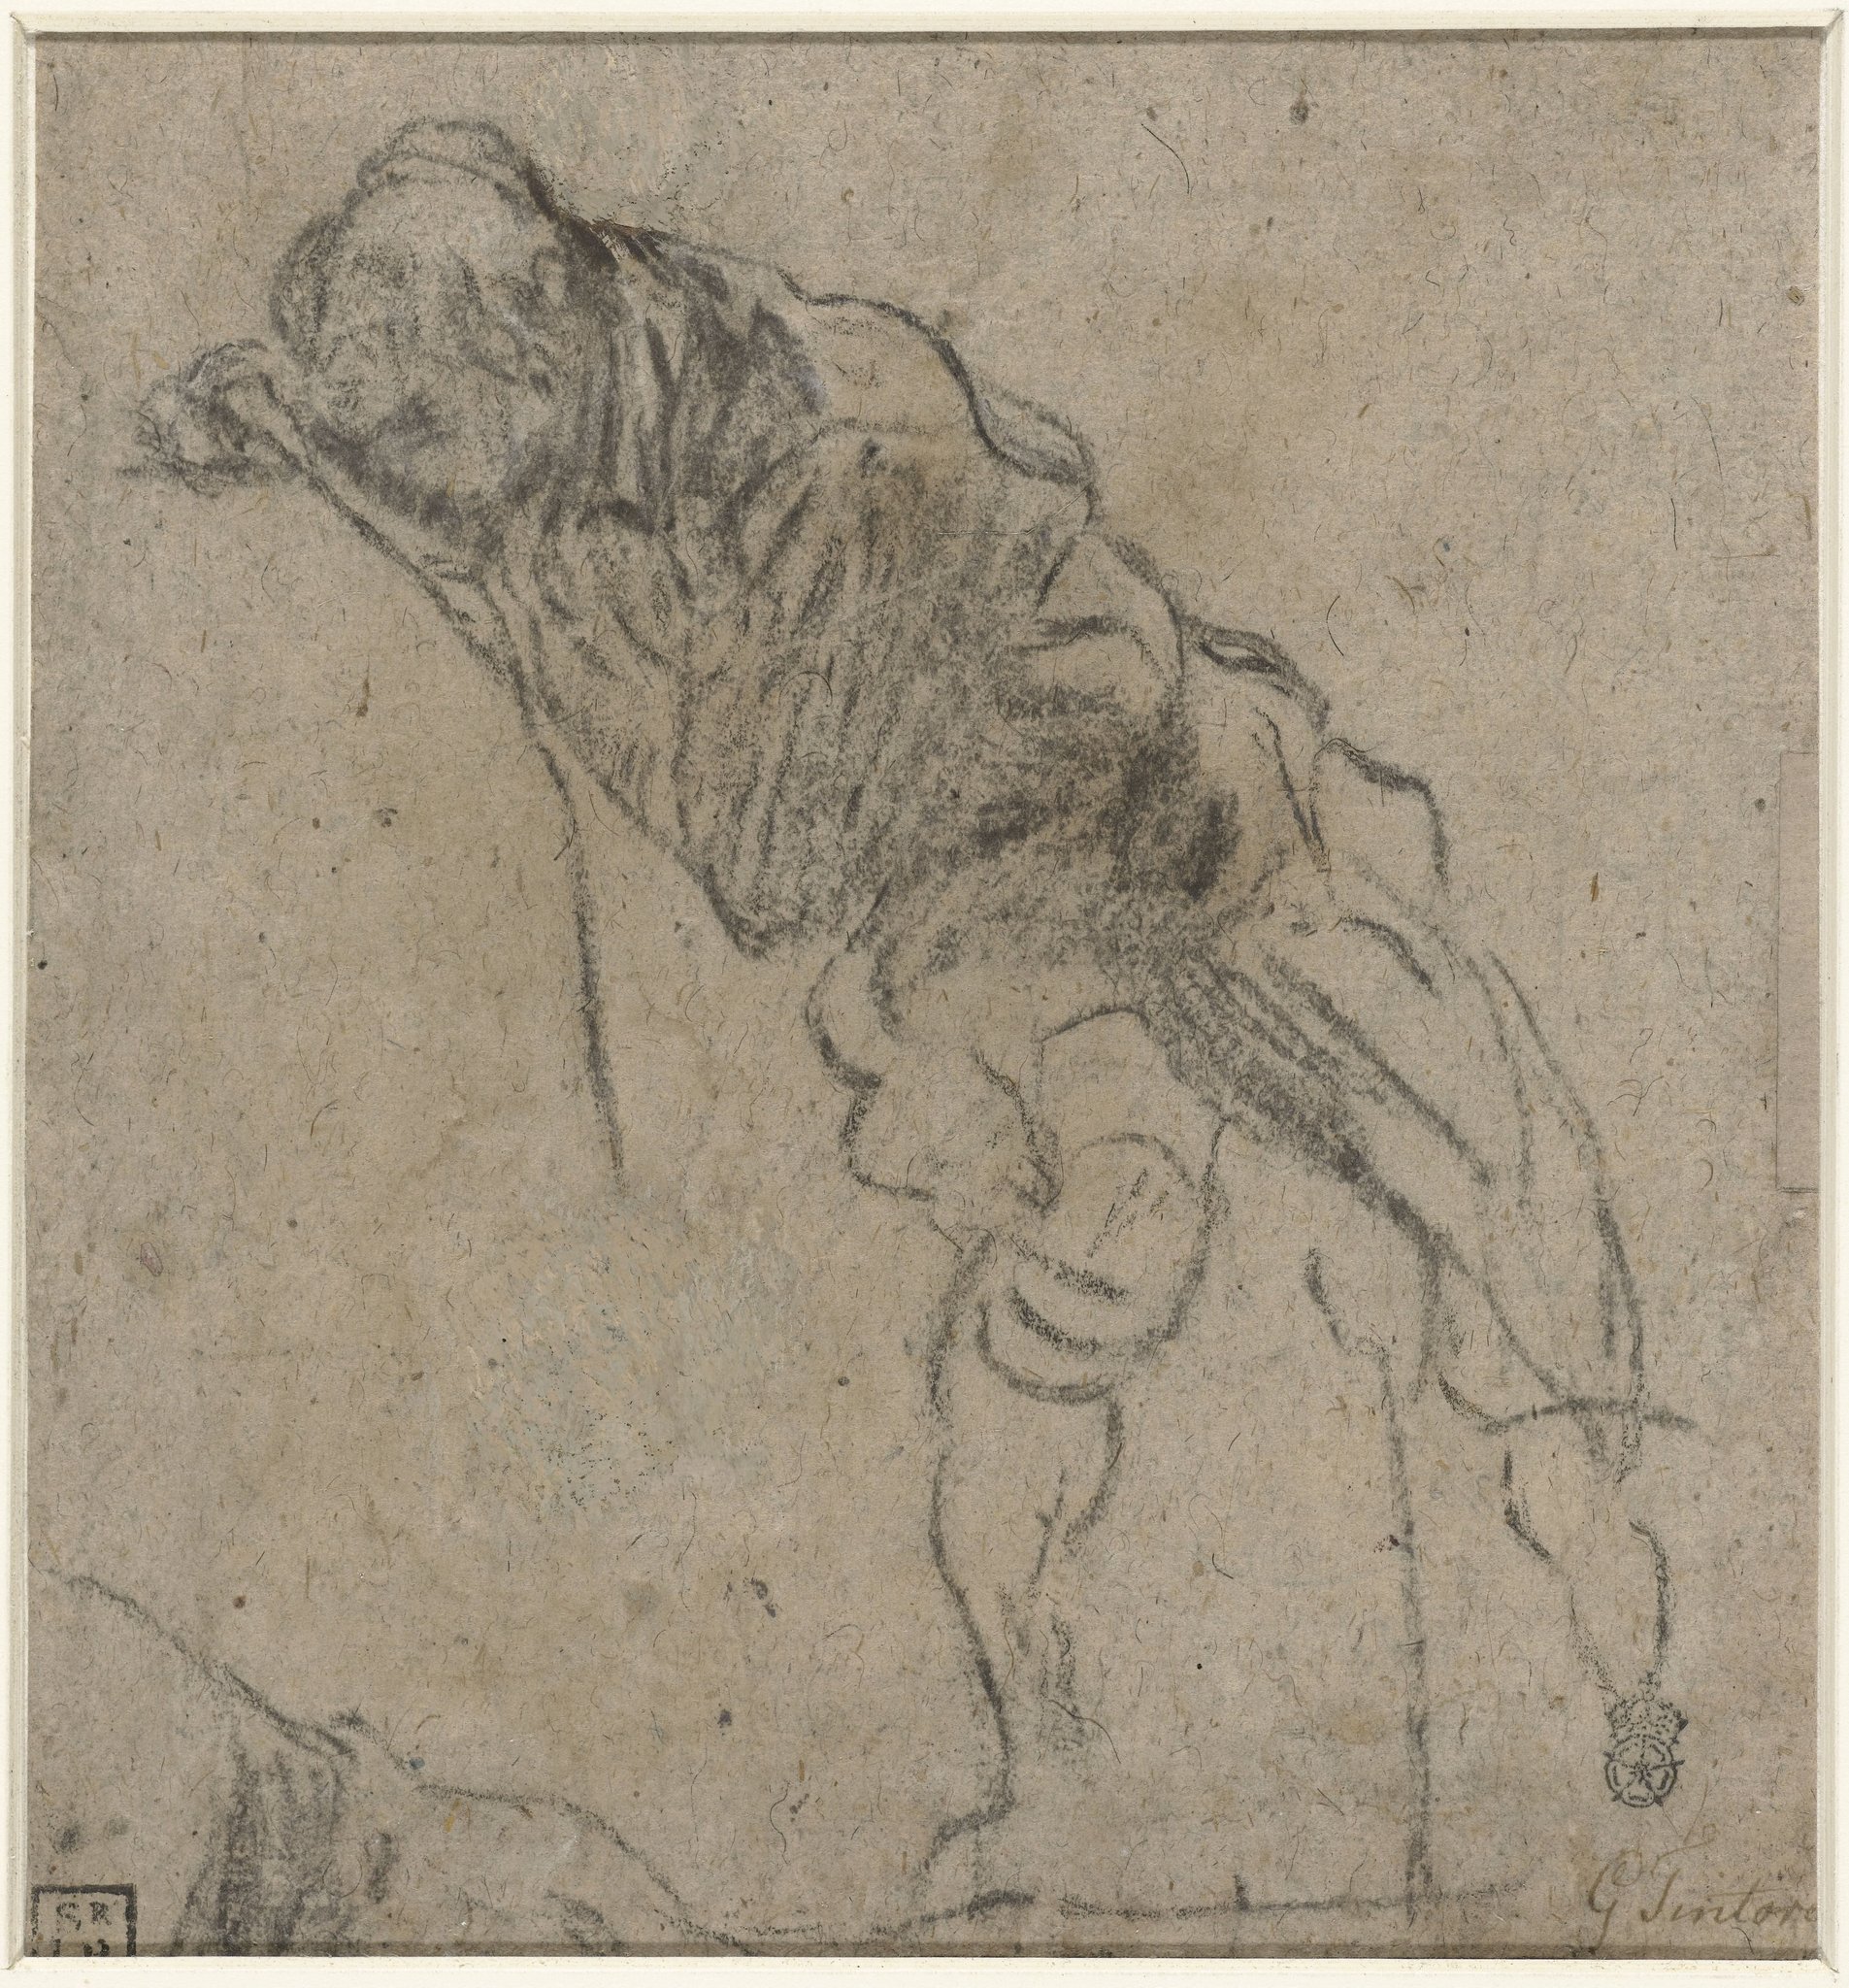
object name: drawing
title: Jongeling die het bovenlichaam opzij buigt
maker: domenico tintoretto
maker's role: draughtsman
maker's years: 1560-1635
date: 1570-1635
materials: paper, chalk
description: Schetsblad met de figuur van een jongeling die het bovenlichaam opzij buigt.